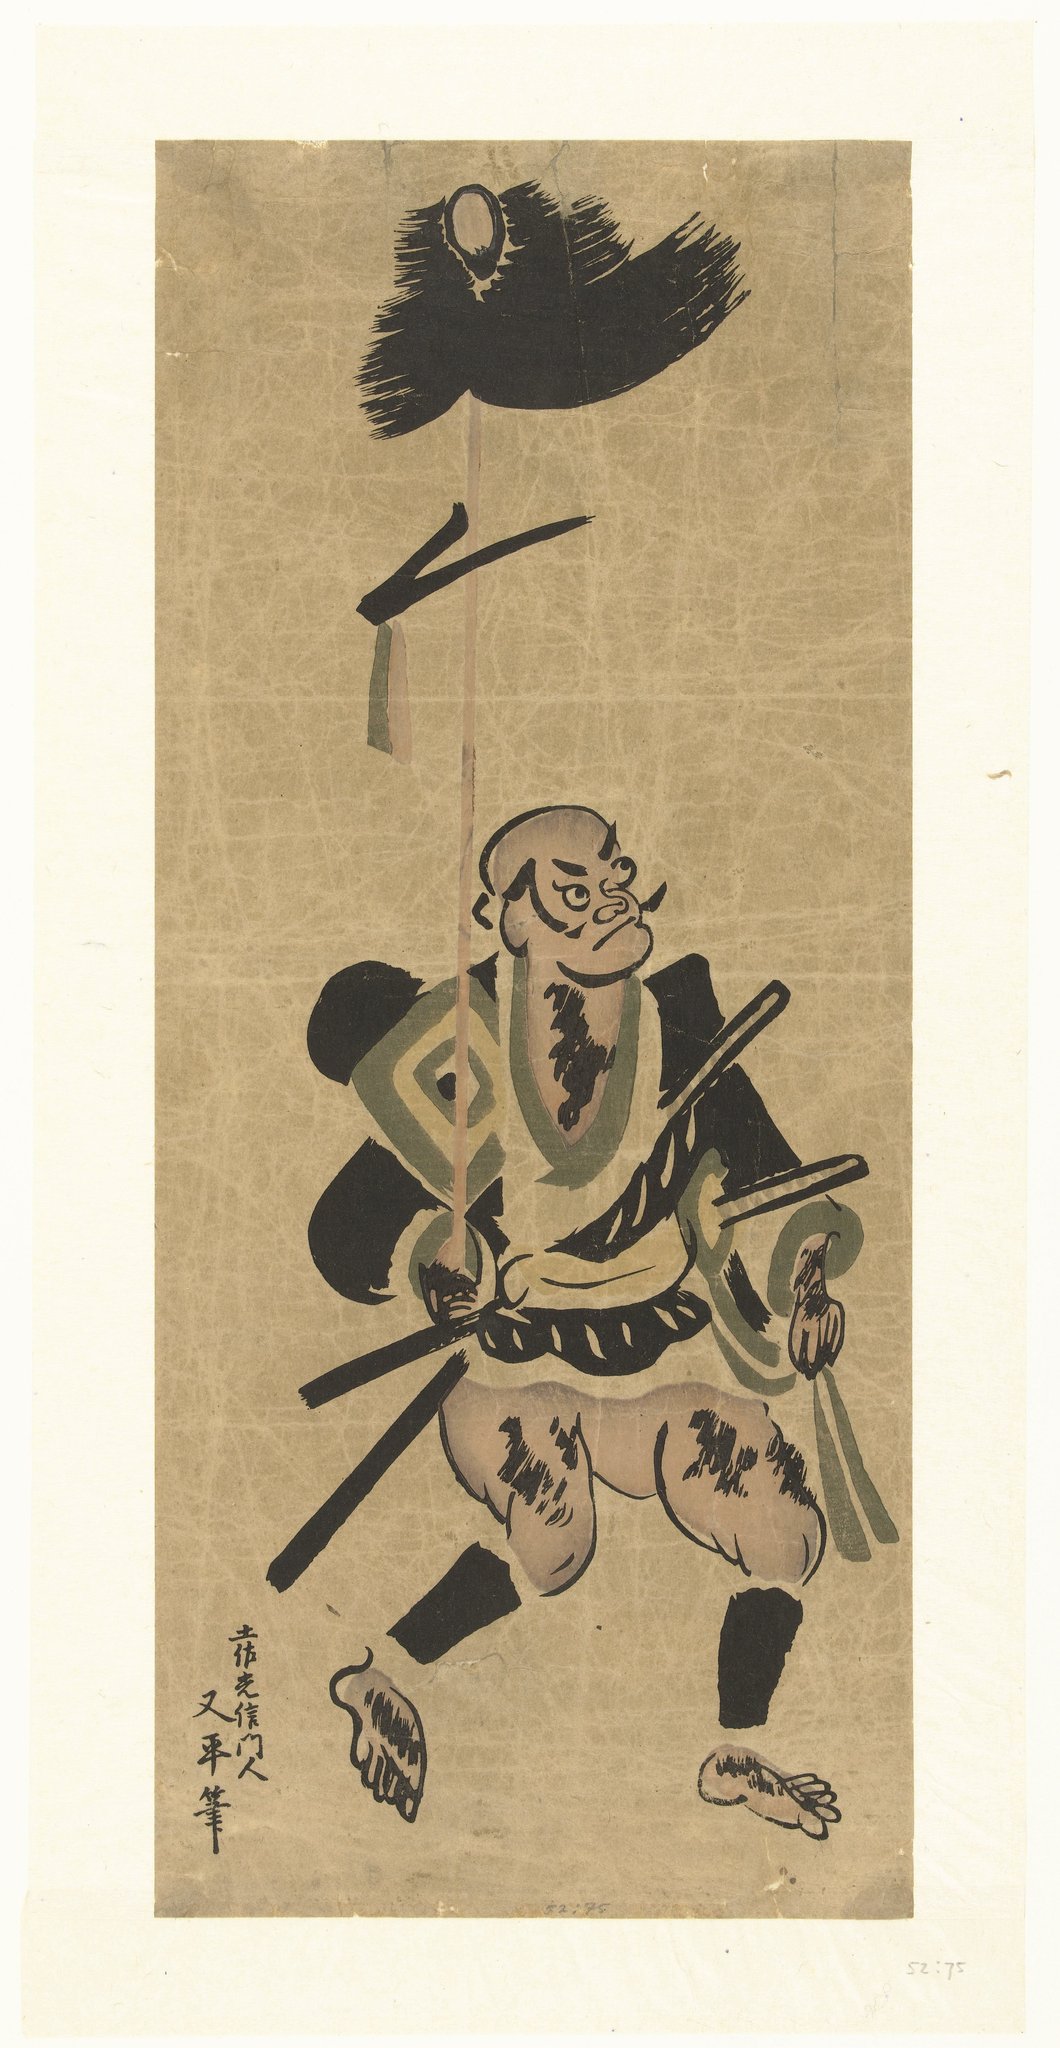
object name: print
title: Toneelspeler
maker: otsu matahei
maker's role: painter, print maker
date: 1700-1730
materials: paper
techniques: woodcut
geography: japan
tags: helved weapons, polearms (for striking, hacking, thrusting), actor (on the stage)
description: Man op blote voeten met opgeheven lans in rechter hand.